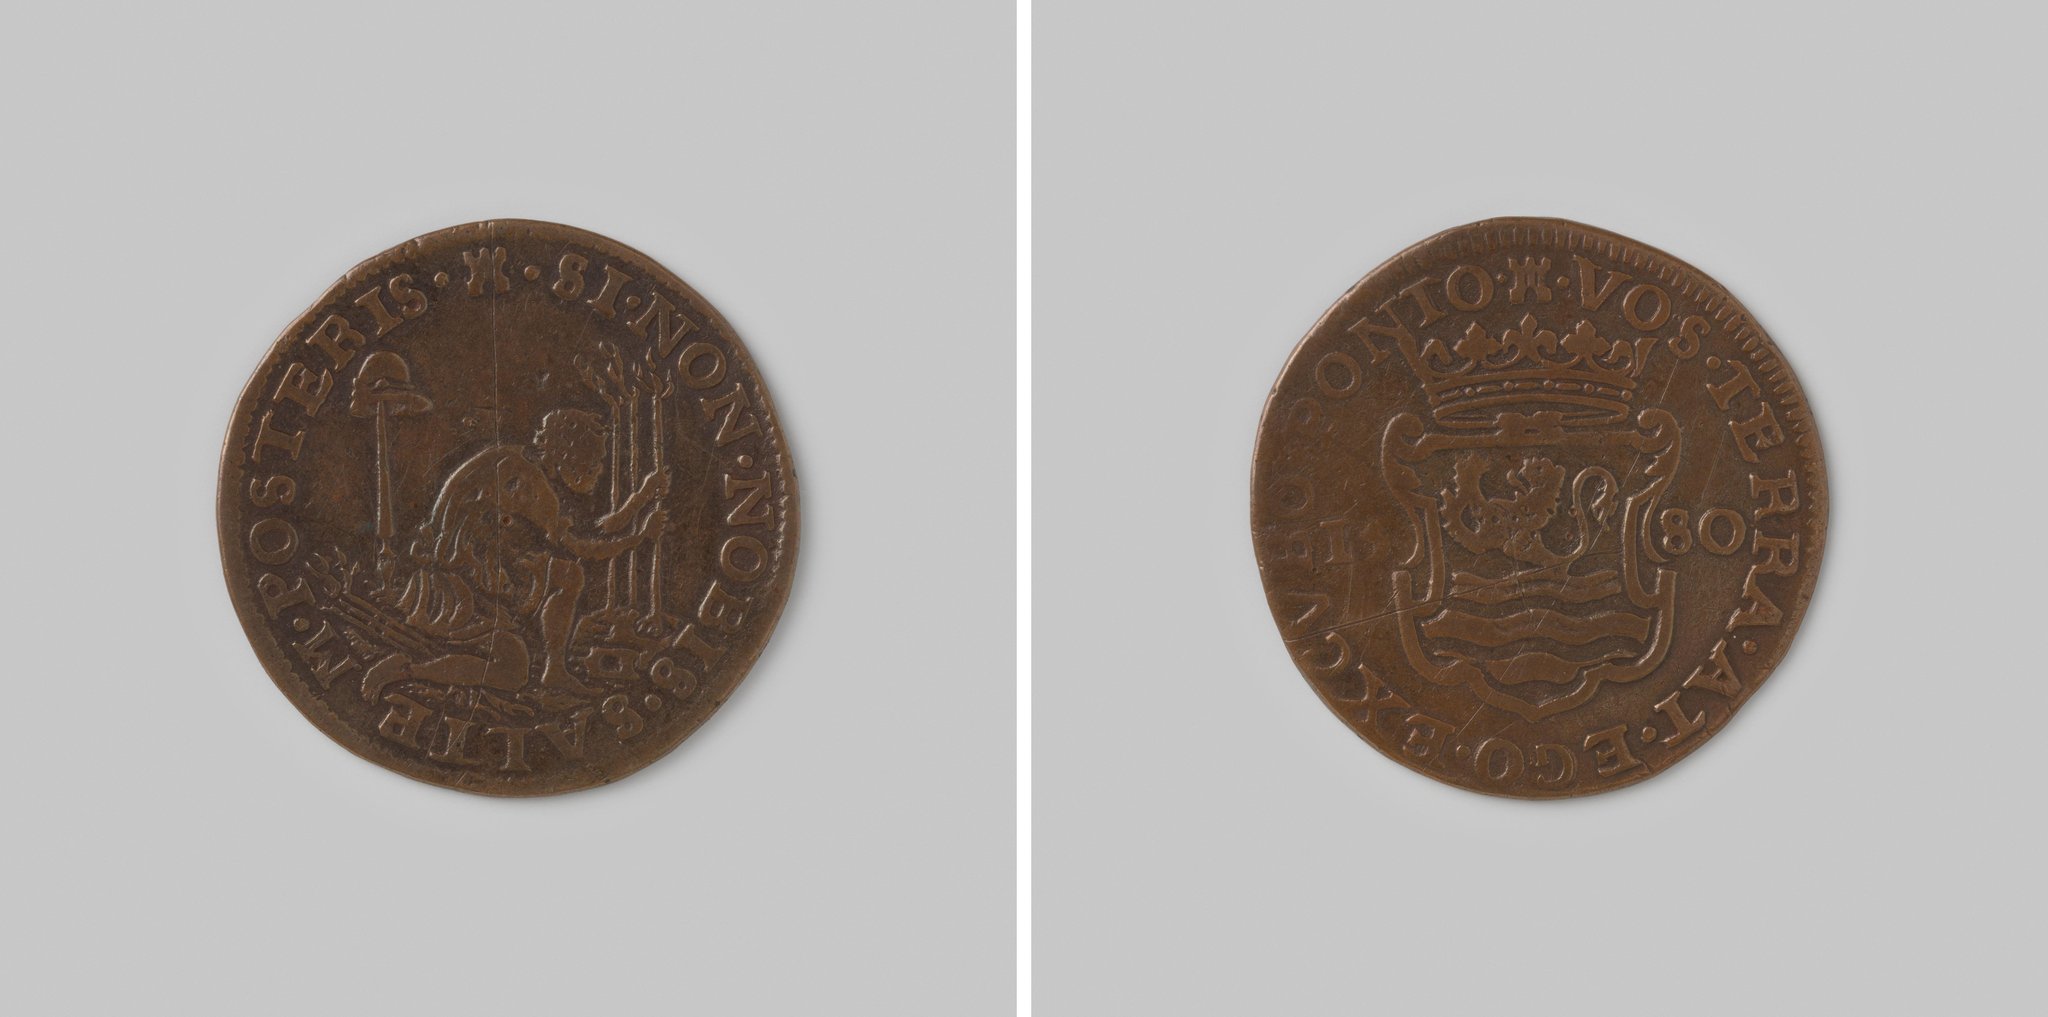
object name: jeton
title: Rekenpenning uit Middelburg op het aanbieden van de soevereiniteit aan Willem van Oranje 1580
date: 1580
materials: copper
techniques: striking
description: Koperen penning, op de voorzijde een boer die oranjebomen plant, achter hem een speer met vrijheidshoed, met omschrift, op de keerzijde het gekroonde wapenschild van Zeeland met het jaartal in het veld en omschrift.